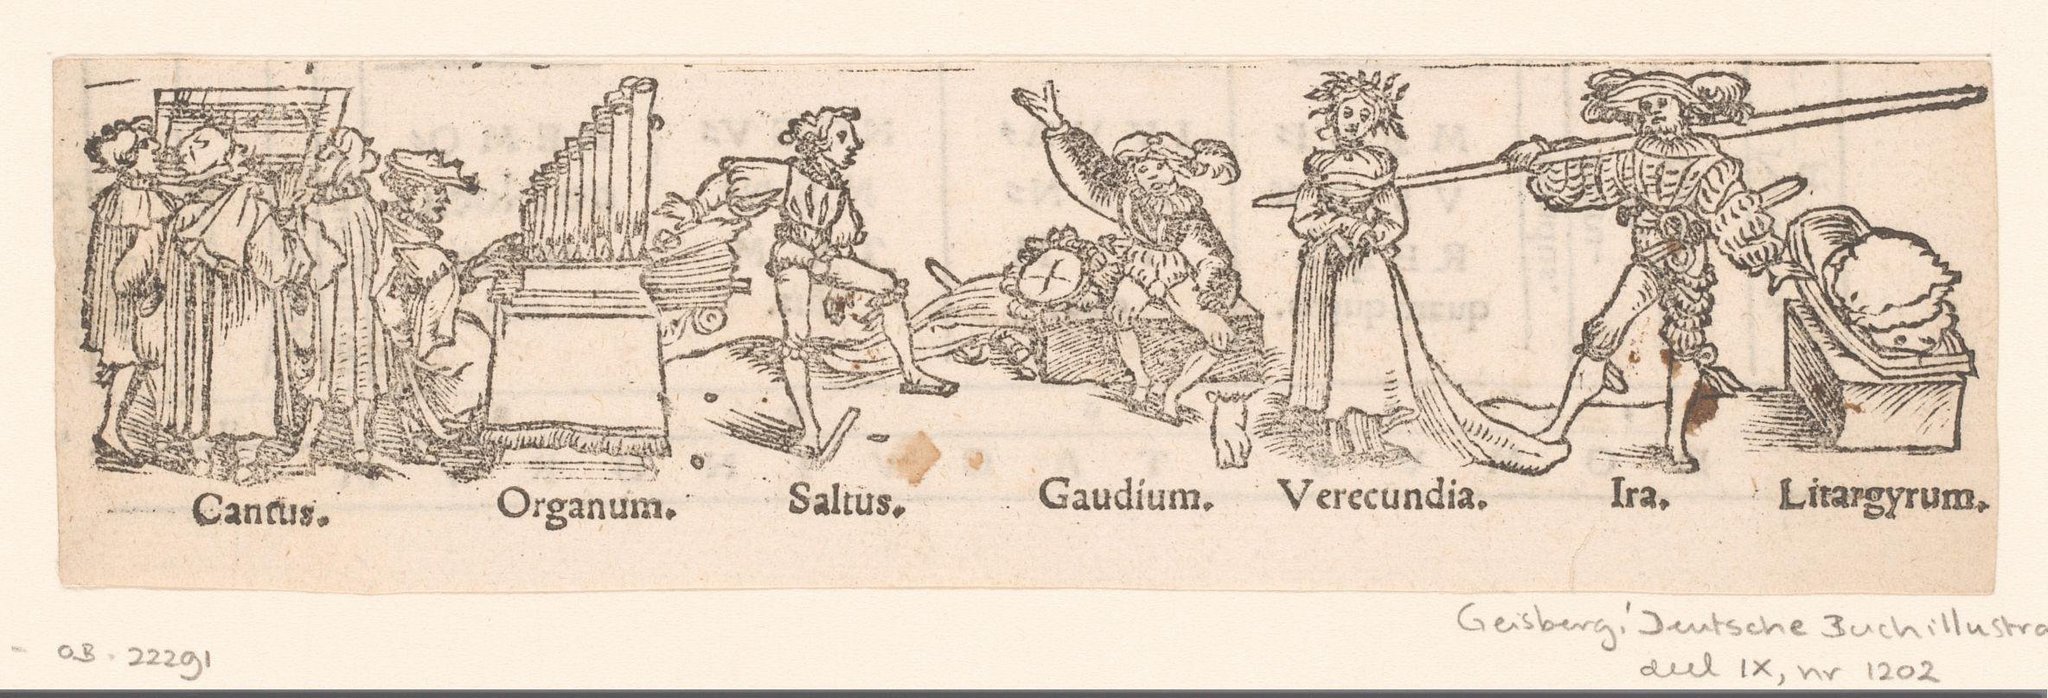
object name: print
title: Reeks van figuren die verschillende bezigheden en emoties verbeelden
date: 1533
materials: paper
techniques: woodcut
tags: human types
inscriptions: collector's mark: Lugt 2228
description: Prent gebruikt in: Newe Künstliche Wohlgerissene und in Holtz geschnittene Figuren. Frankfurt am Main: Vincentius Steinmeyer, 1620.